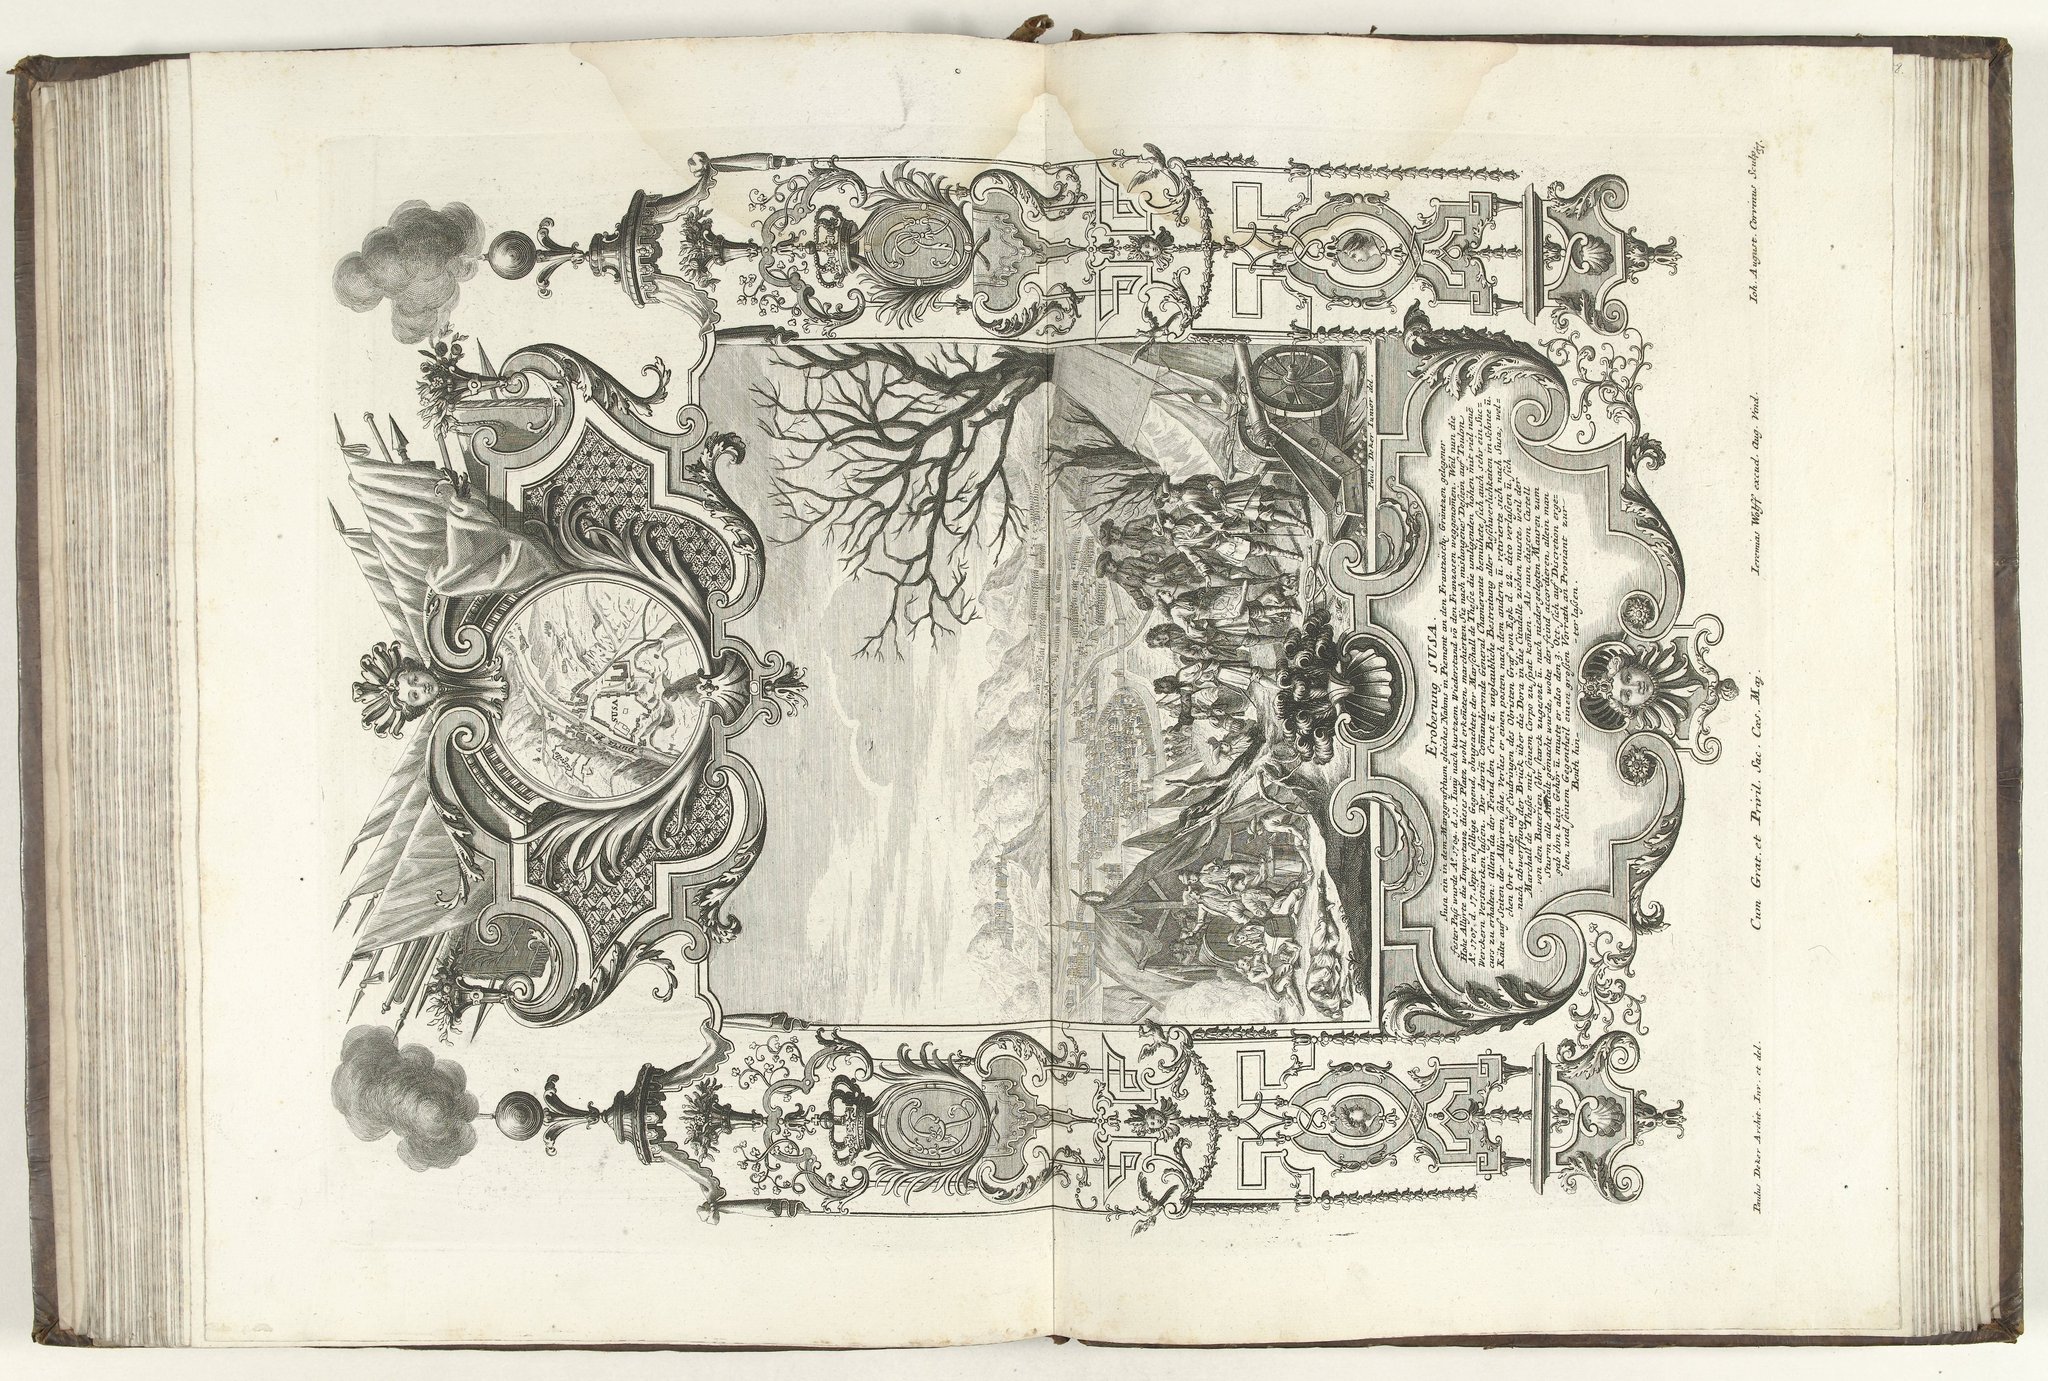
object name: history print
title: Verovering van Susa, 1707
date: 1712-1715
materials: paper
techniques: engraving, etching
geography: augsburg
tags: vienna, charles vi (holy roman emperor), siege, position war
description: Beleg en verovering van de kleine vesting Susa in Piemonte door de Geallieerde troepen namens koning Karel III, 3 oktober 1707. De centrale voorstelling van het beleg in een rijk versierde ornamentele omlijsting met bovenaan een cartouche met een plattegrond van de vesting. Onderaan een cartouche met de beschrijving van de gebeurtenissen in het Duits, links en rechts wapens met het monogram CR van Carolus Rex. Blad in de gebonden verzameling platen uitgebracht onder de titel: Repraesentatio belli ... Der Spanische Successions-Krieg [ca. 1720].